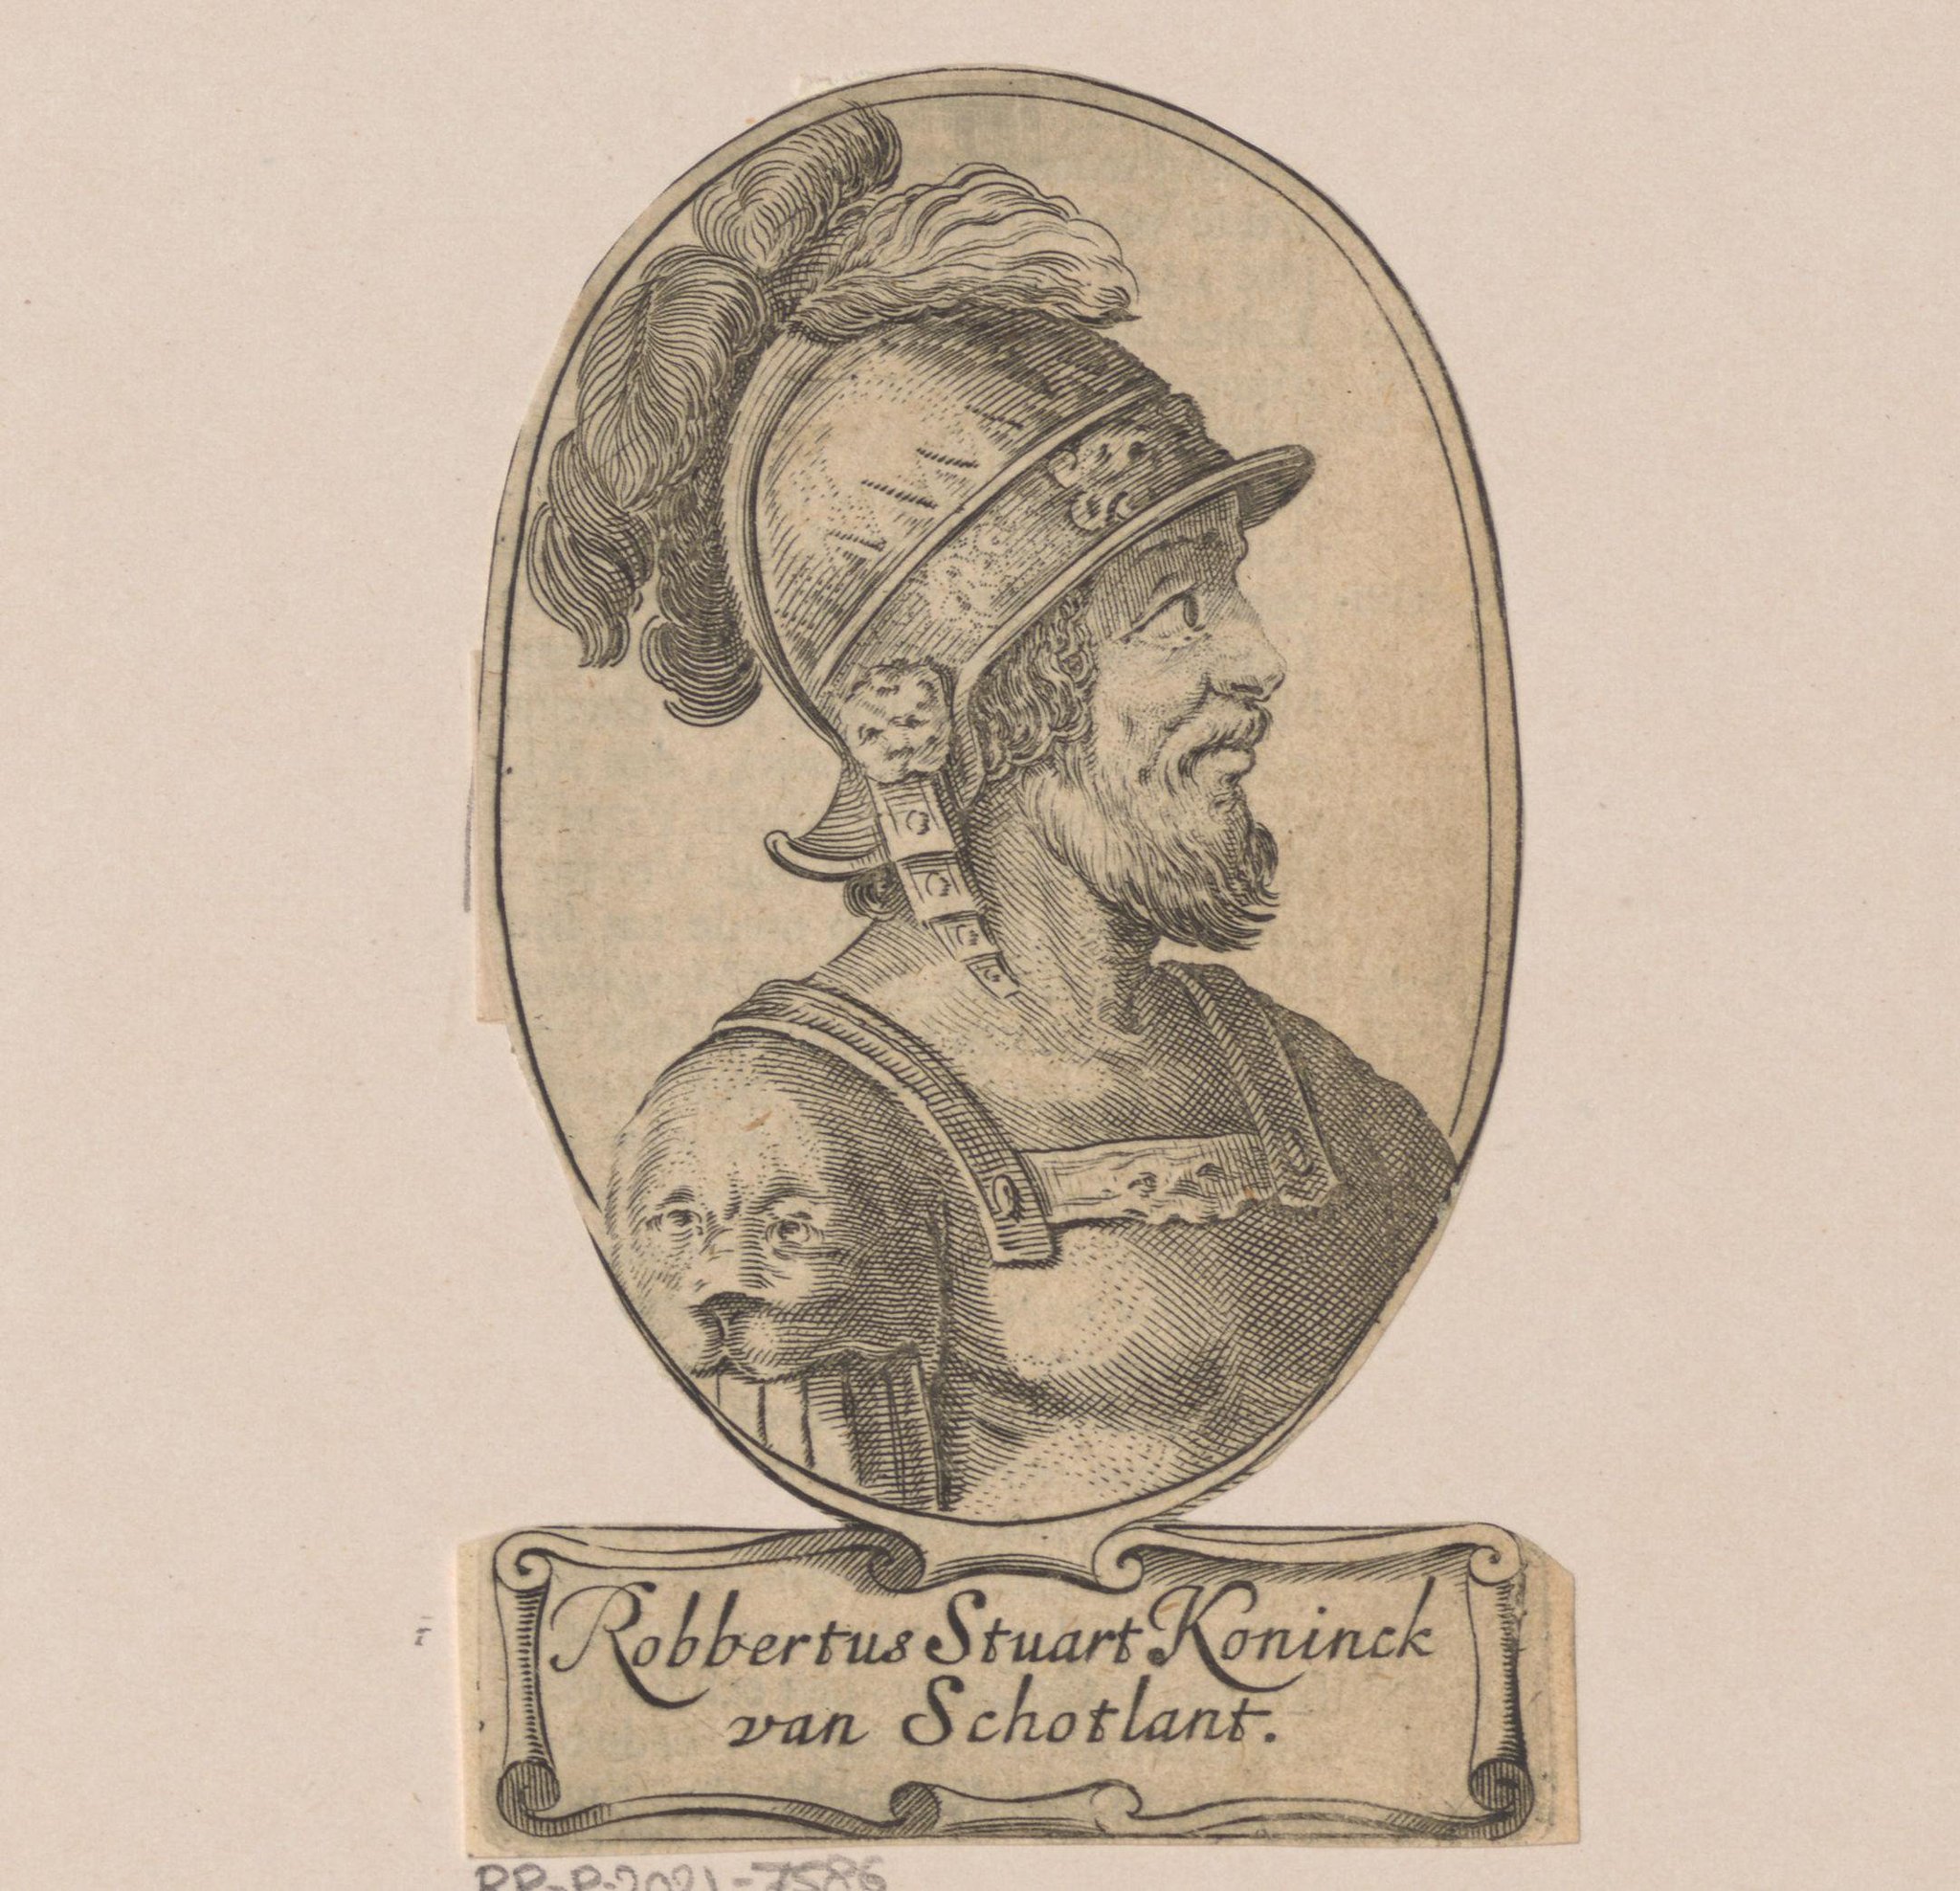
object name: book illustration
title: Portret van Robert II, koning van Schotland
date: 1650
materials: paper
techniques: engraving, letterpress printing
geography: dordrecht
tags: historical persons, king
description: Prent uit: Oort, Jacob van. Stuardts ongeluckige heerschappye (...). Dordrecht: Abraham Andriesz., 1650, dl. 1.